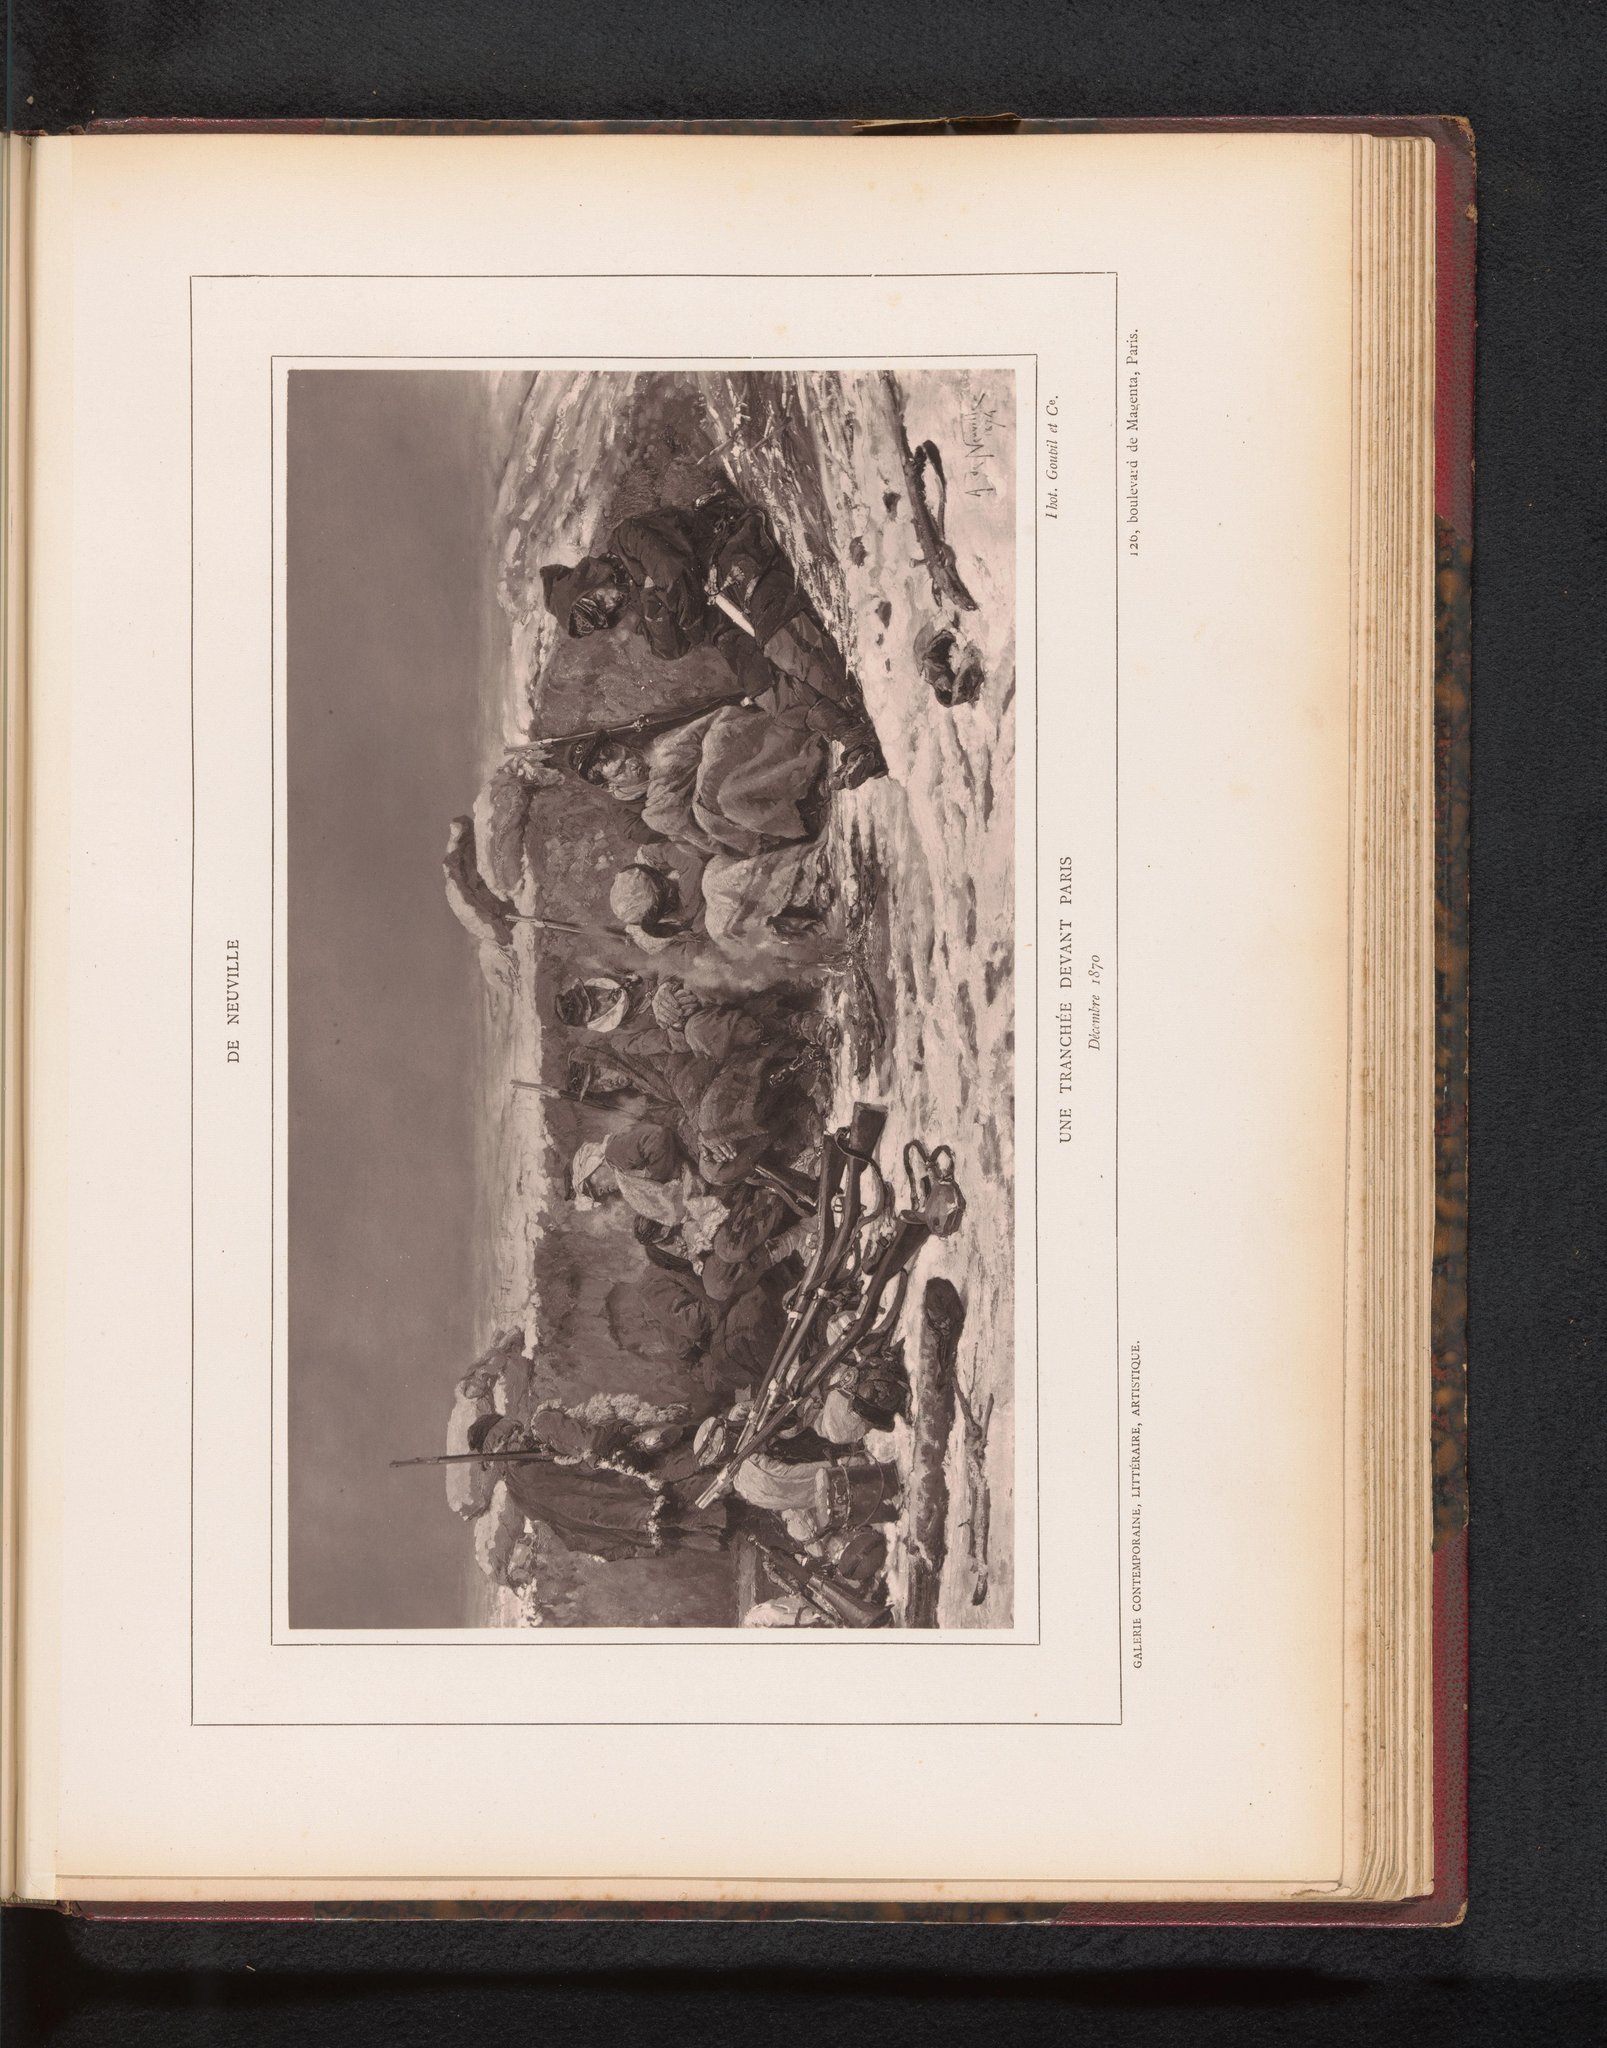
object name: photomechanical print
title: Une tranchée devant Paris - Décembre 1870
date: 1871-1876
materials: paper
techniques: woodburytype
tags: the soldier; the soldier's life, painting, drawing and the graphic arts, trenches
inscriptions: inscription: ‘De Neuville/ Galerie Contemporaine, Littéraire et Artistique/ 126, boulevard de Magenta, Paris.’